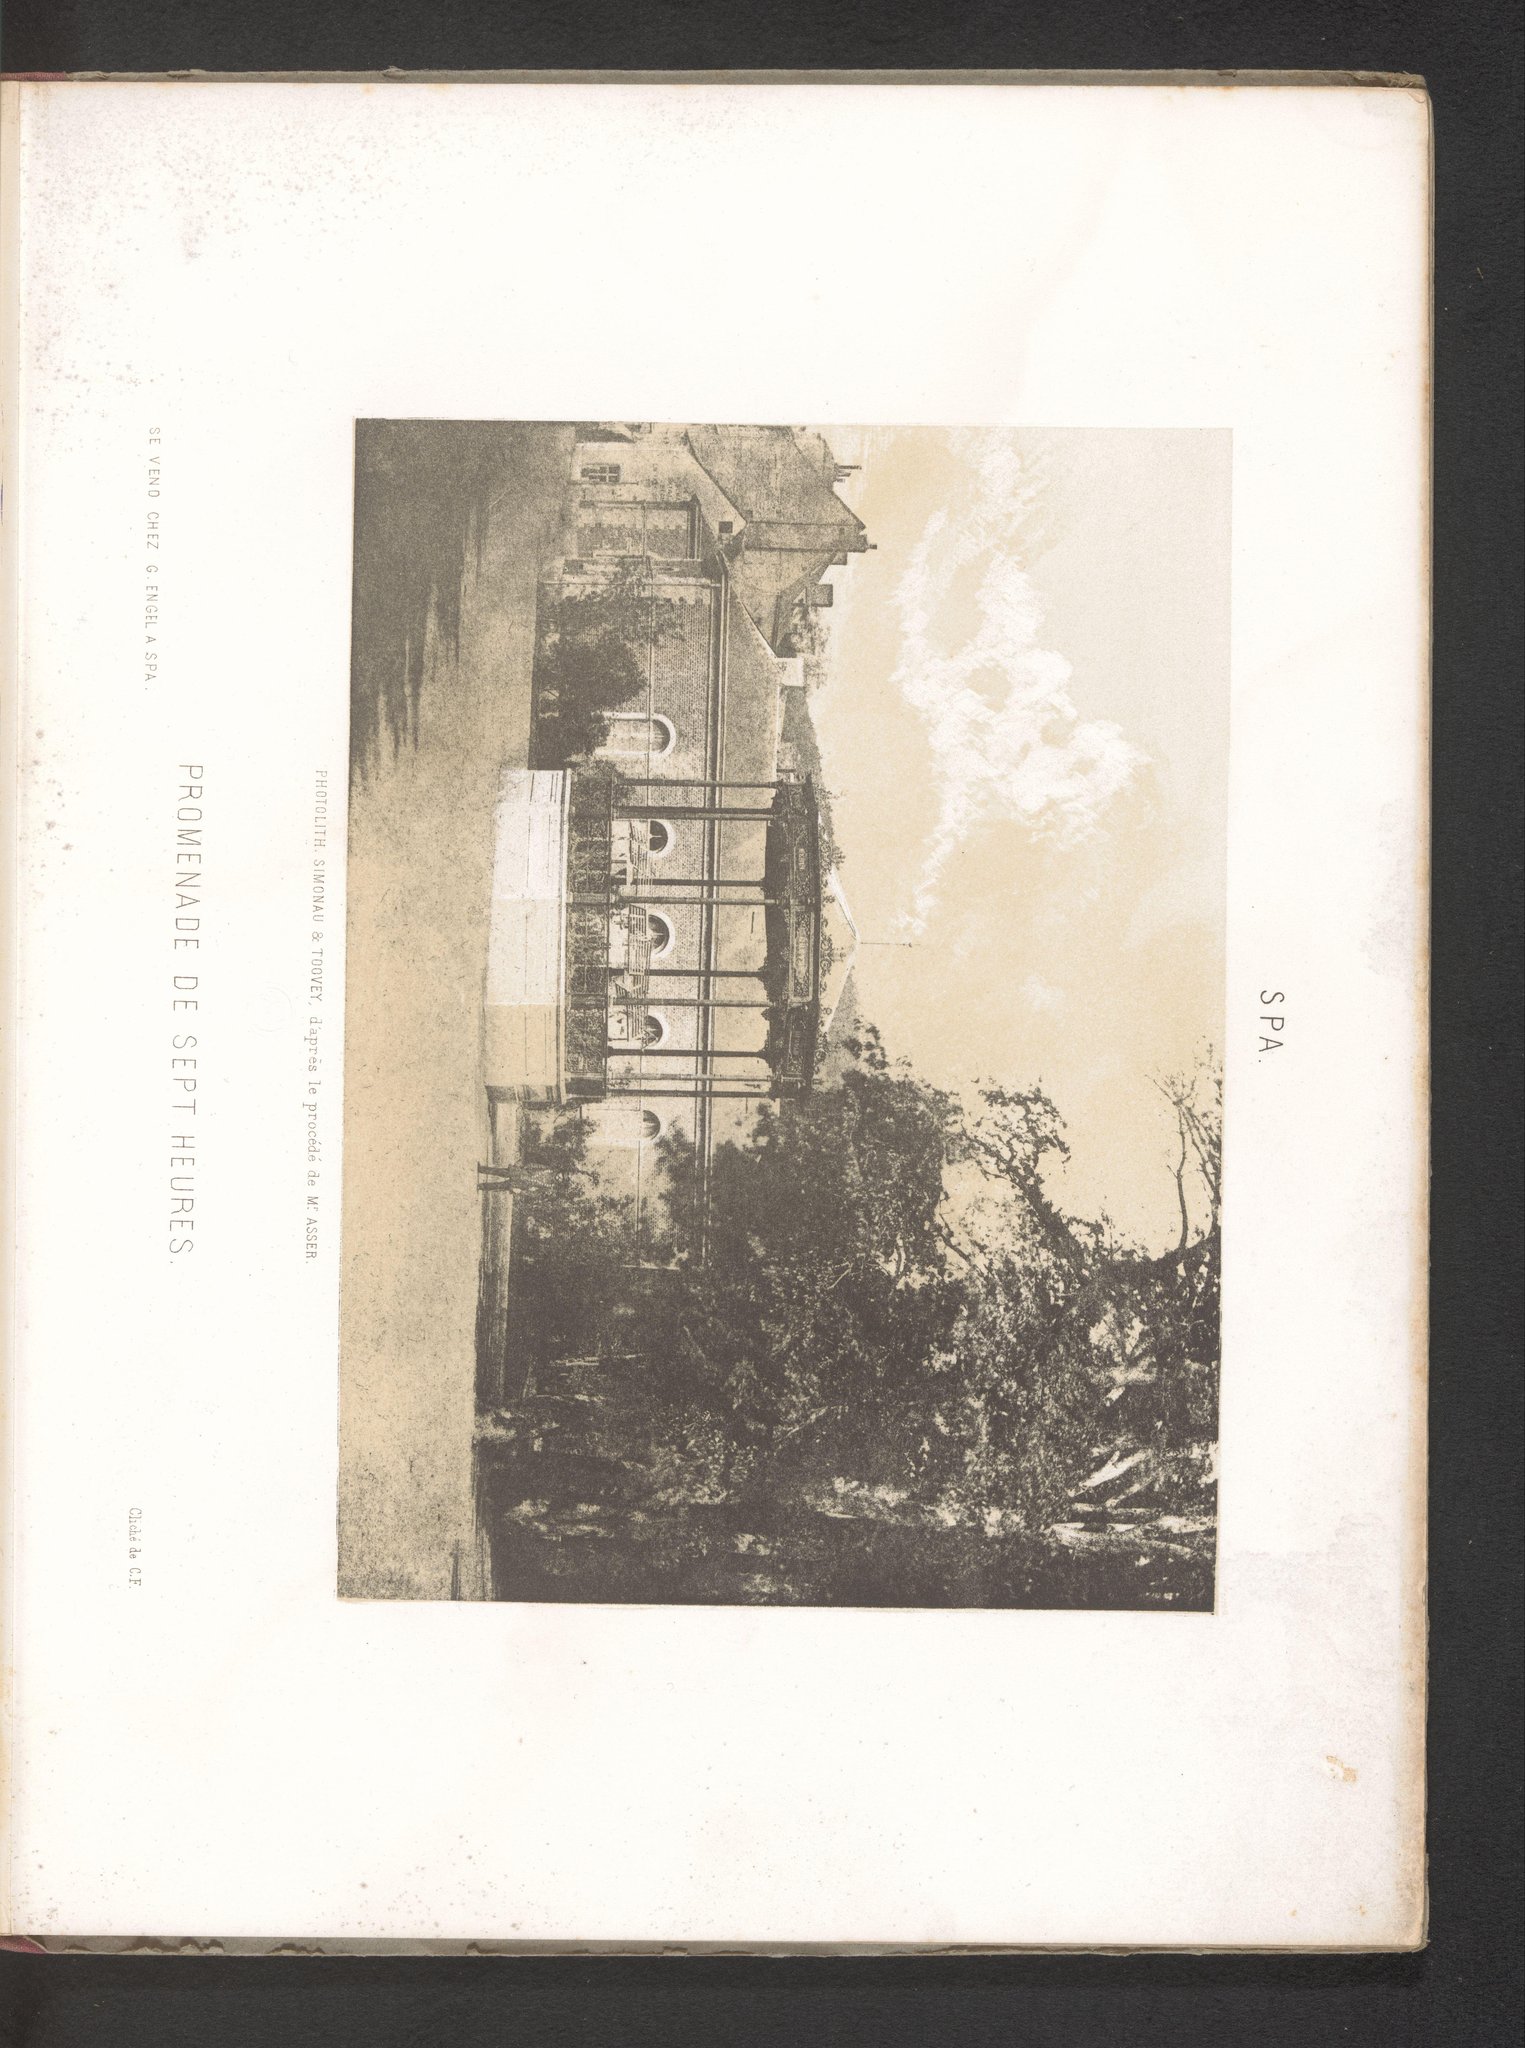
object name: page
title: Promenade de Sept Heures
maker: c.f.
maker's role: fotograaf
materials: paper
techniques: photolithography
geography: spa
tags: avenue, boulevard, promenade, esplanade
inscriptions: inscription: ‘SE VEND CHEZ F. ENGEL A SPA.’, inscription: ‘PHOTOLITH. SIMONAU & TOOVEY, d'après le procédé de Mr. ASSER.’, collector's mark: ‘EA’